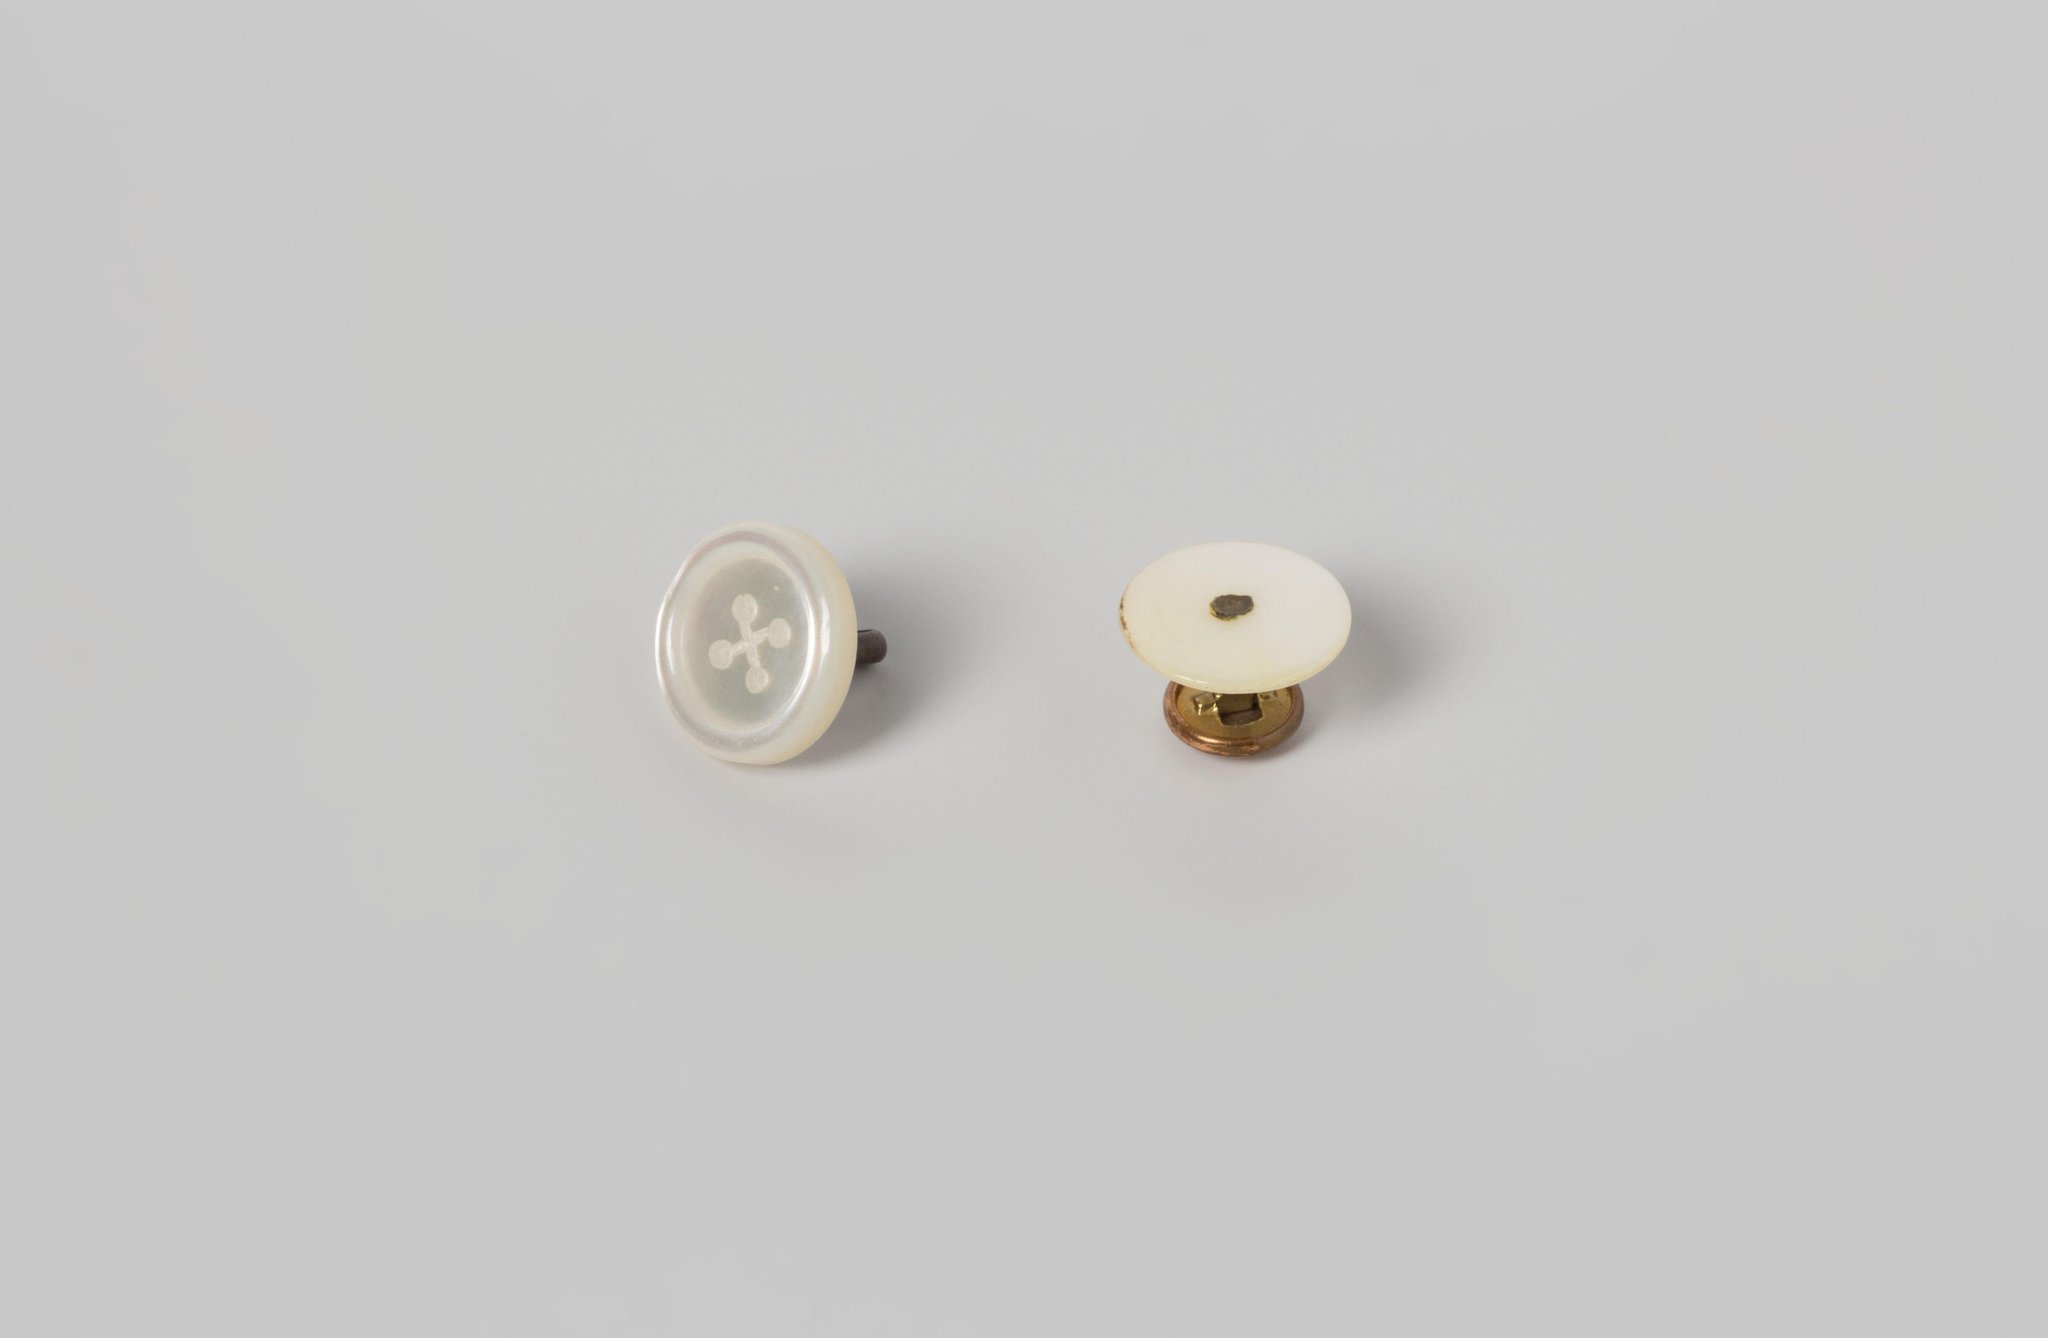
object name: vestknoop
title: Vestknoop van koper met parelmoer met vast oogje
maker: Anonymous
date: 1900-1940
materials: copper, mother of pearl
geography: netherlands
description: Vestknoop van koper met parelmoer met vast oogje.